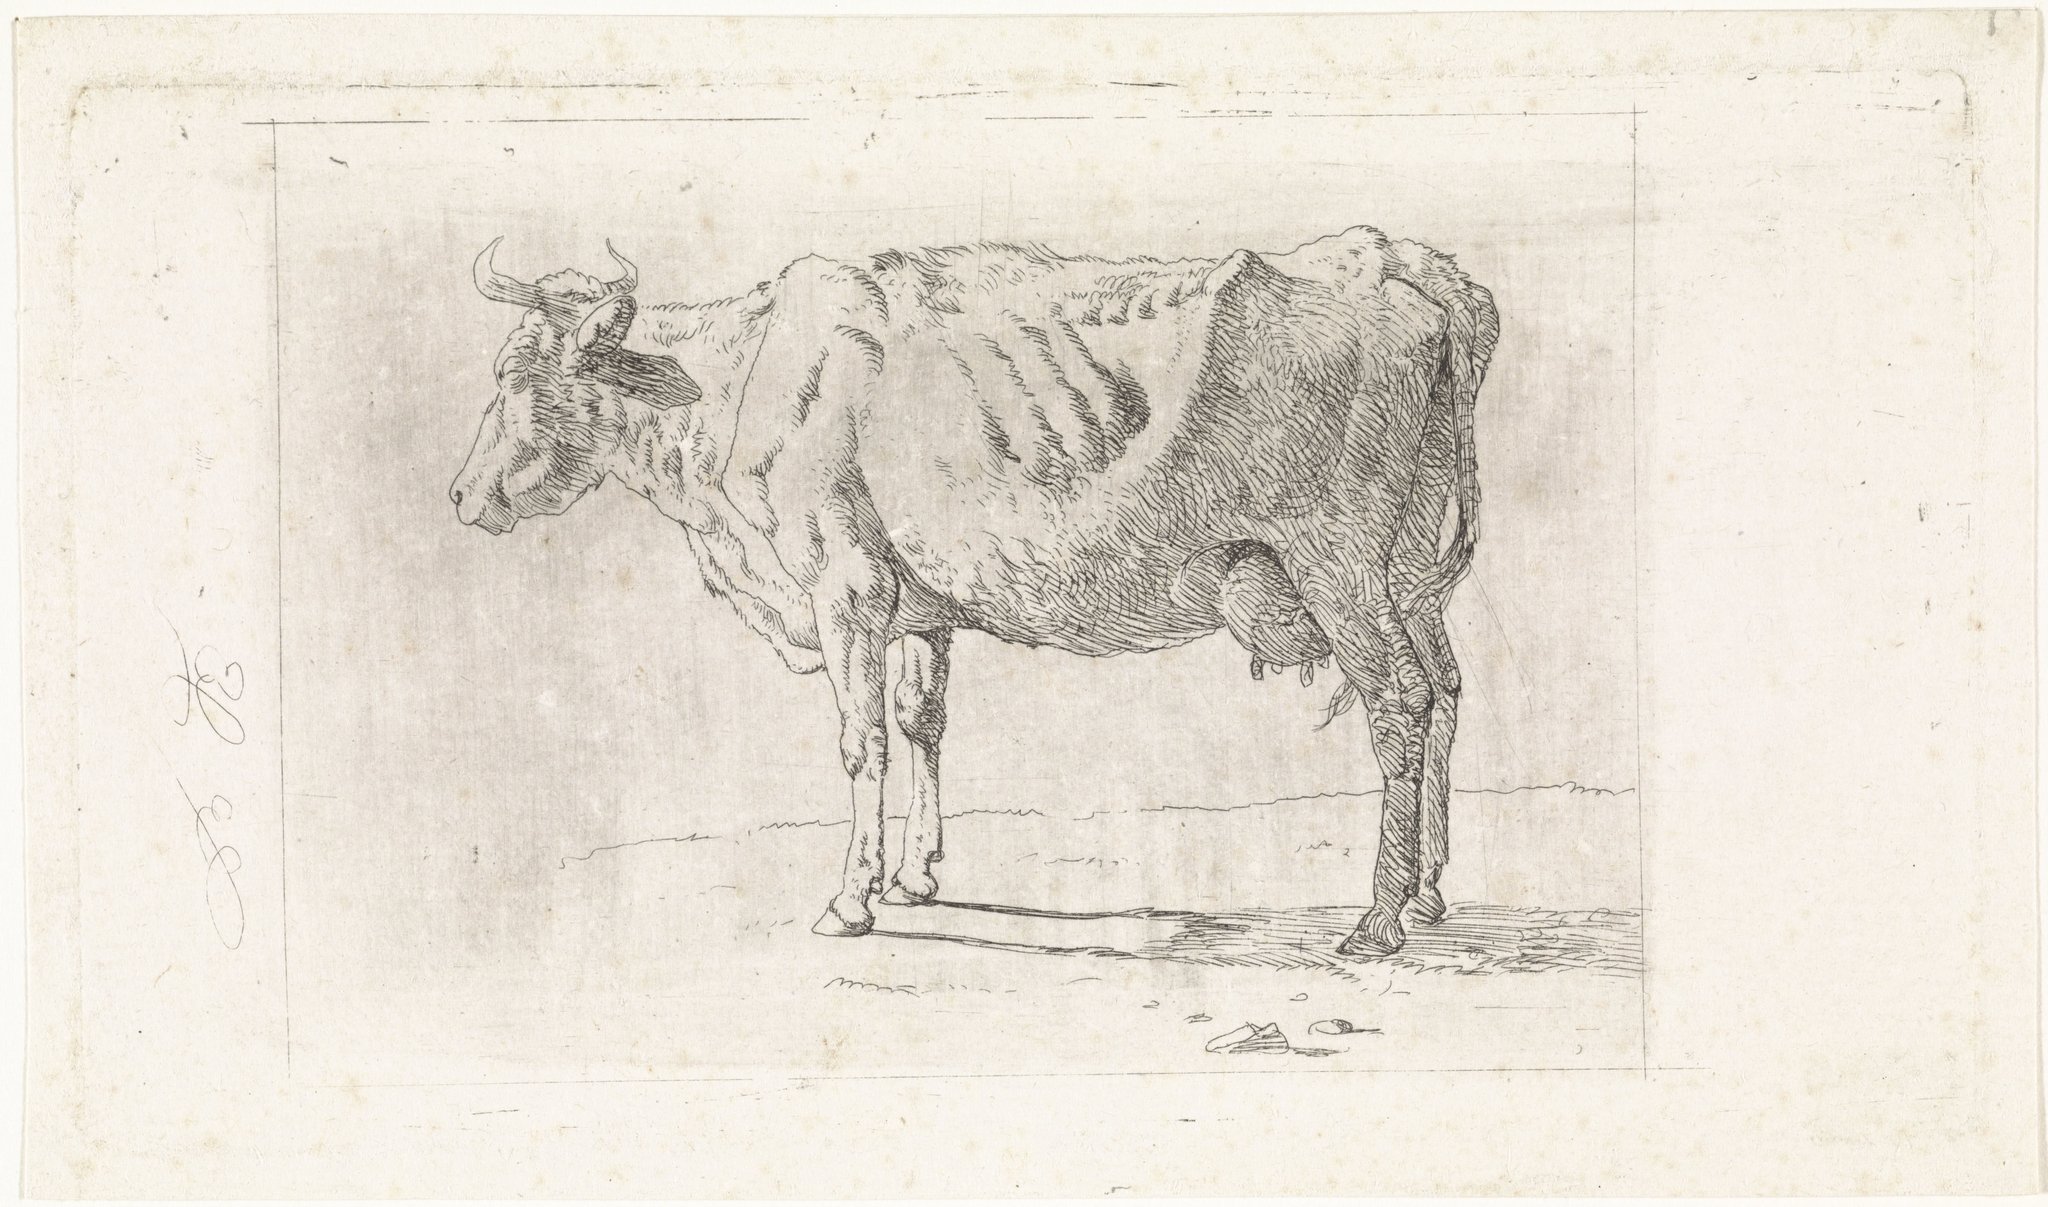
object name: print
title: Staande koe, naar links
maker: wouter johannes van troostwijk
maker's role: draughtsman, painter, print maker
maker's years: 1782-1810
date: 1792-1810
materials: paper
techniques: etching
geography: amsterdam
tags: cow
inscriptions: collector's mark: Lugt 2165